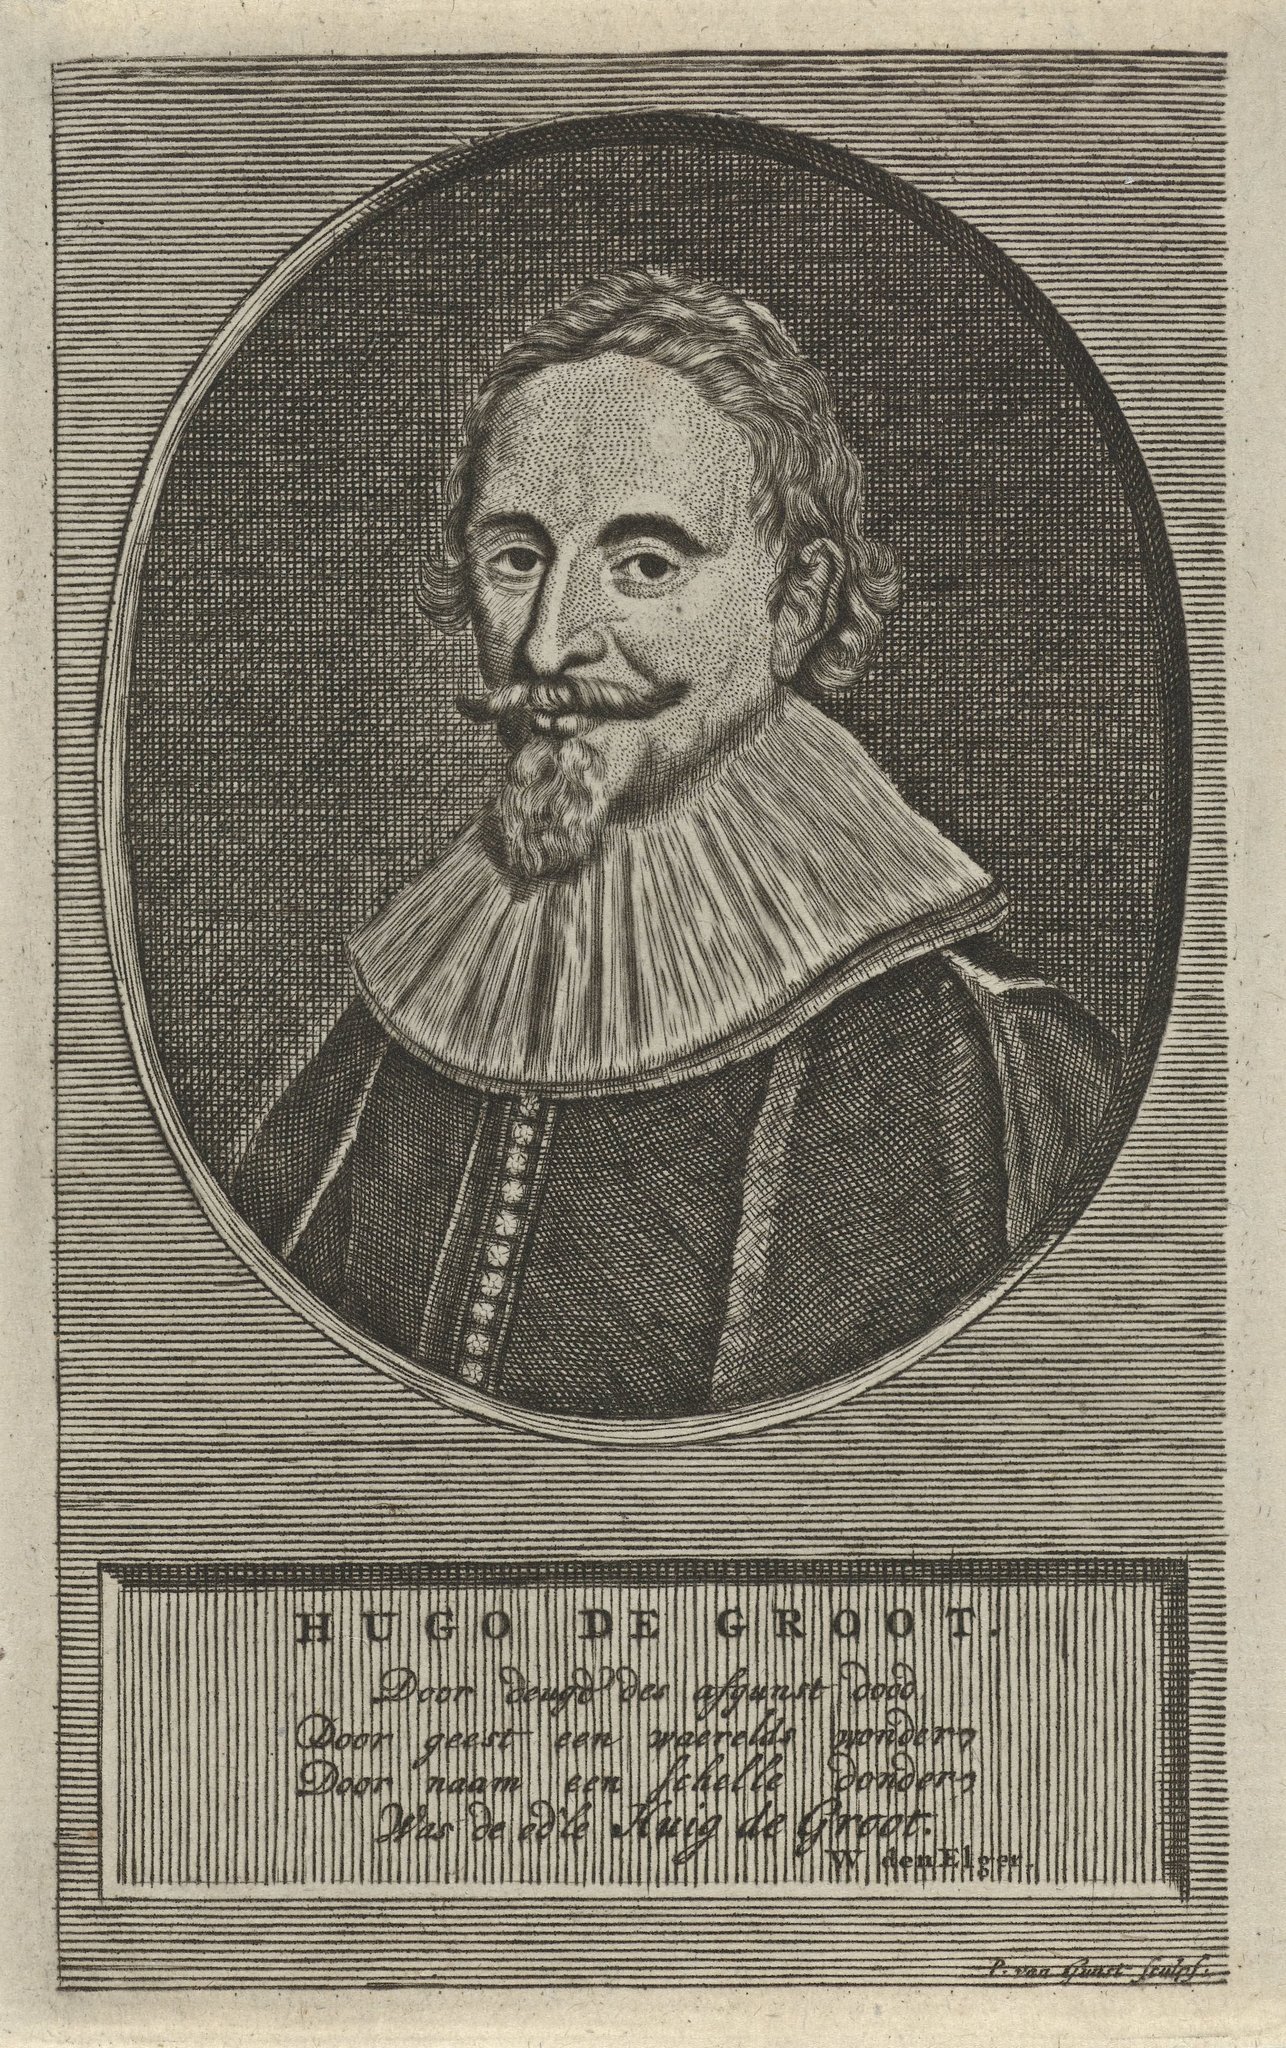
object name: print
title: Portret van Hugo de Groot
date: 1669-1731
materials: paper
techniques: drypoint, engraving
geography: amsterdam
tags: delft, hugo de groot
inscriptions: collector's mark: Lugt 2228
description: Hugo de Groot, Nederlands dichter, schrijver en rechtsgeleerde. De prent heeft een Nederlands gedicht als onderschrift.